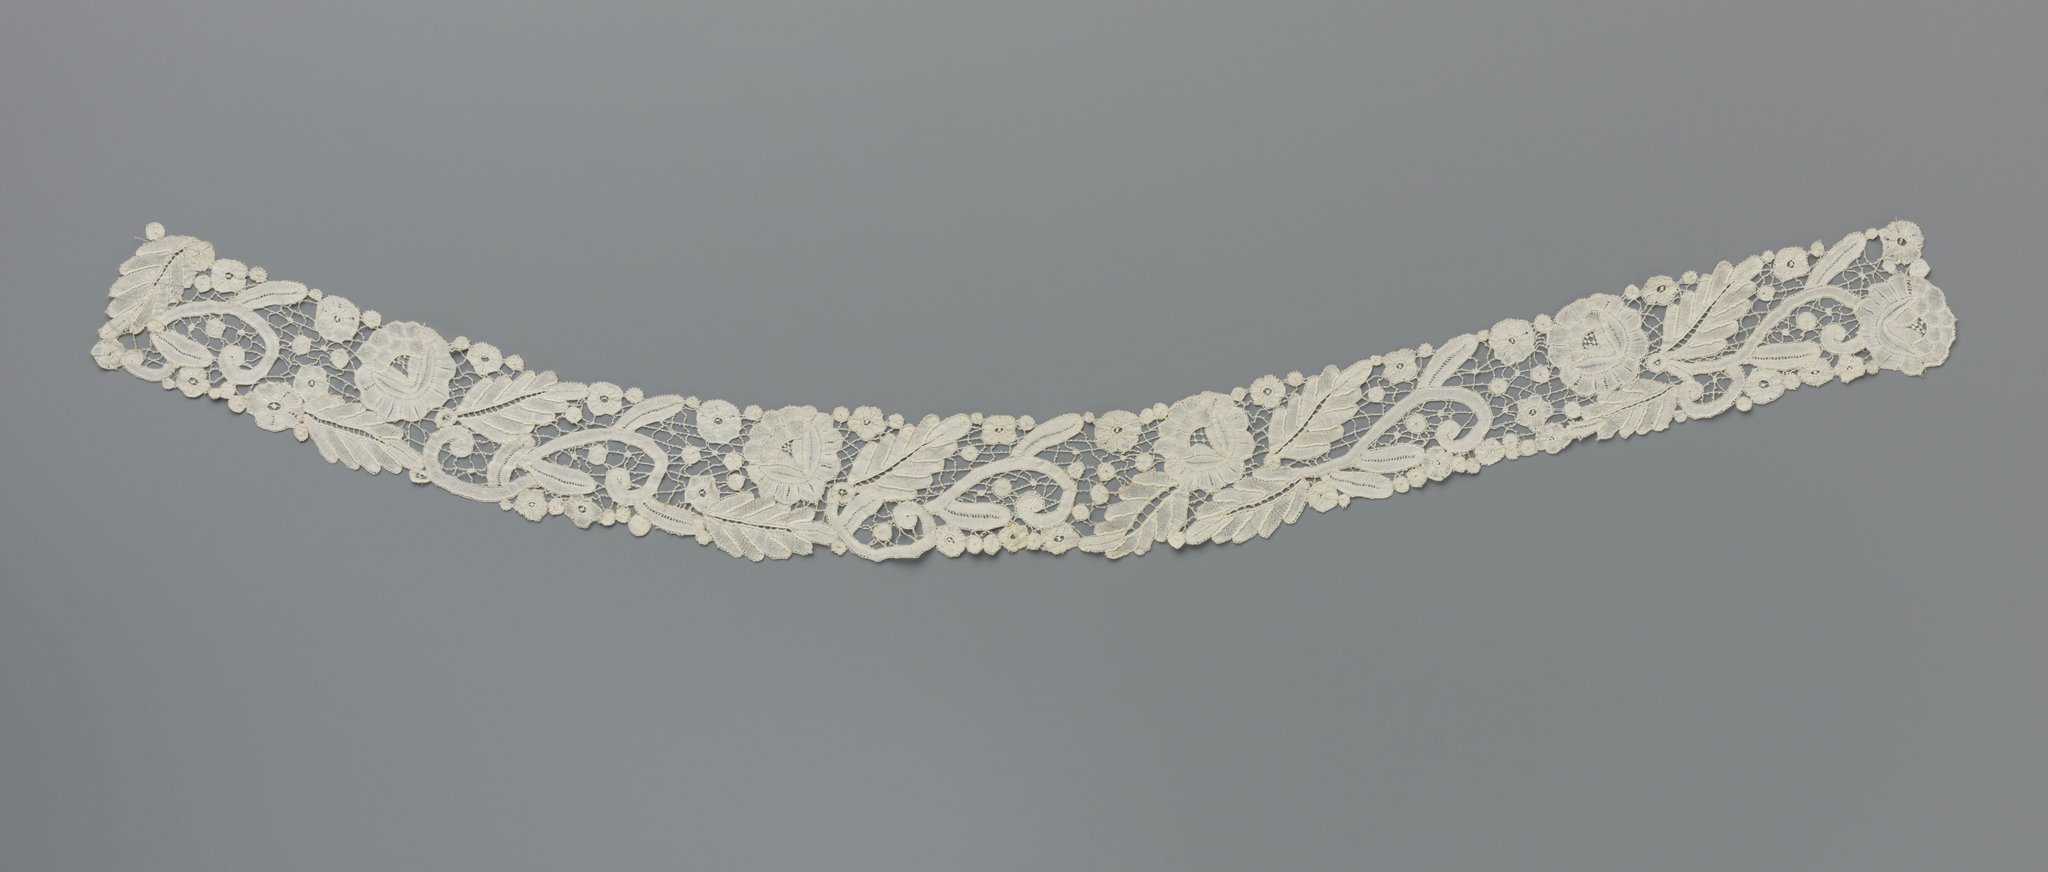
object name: sierstuk, sierobject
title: Sierstuk voor een avondmantel van gemengde kant met rozenhaag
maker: martha berkers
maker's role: kantwerkster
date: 1915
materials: linen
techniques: lace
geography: sluis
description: Sierstuk voor een avondmantel van naturelkleurige gemengde kant - kloskant in combinatie met naaldkant - Brusselse duchesse. Op een wijd gespreide vlechtengrond staan rozen die meestal op twee bladeren steunen. Een tussenornament bestaat uit enkele en dubbele voluutranken en vele kleine bloempjes.